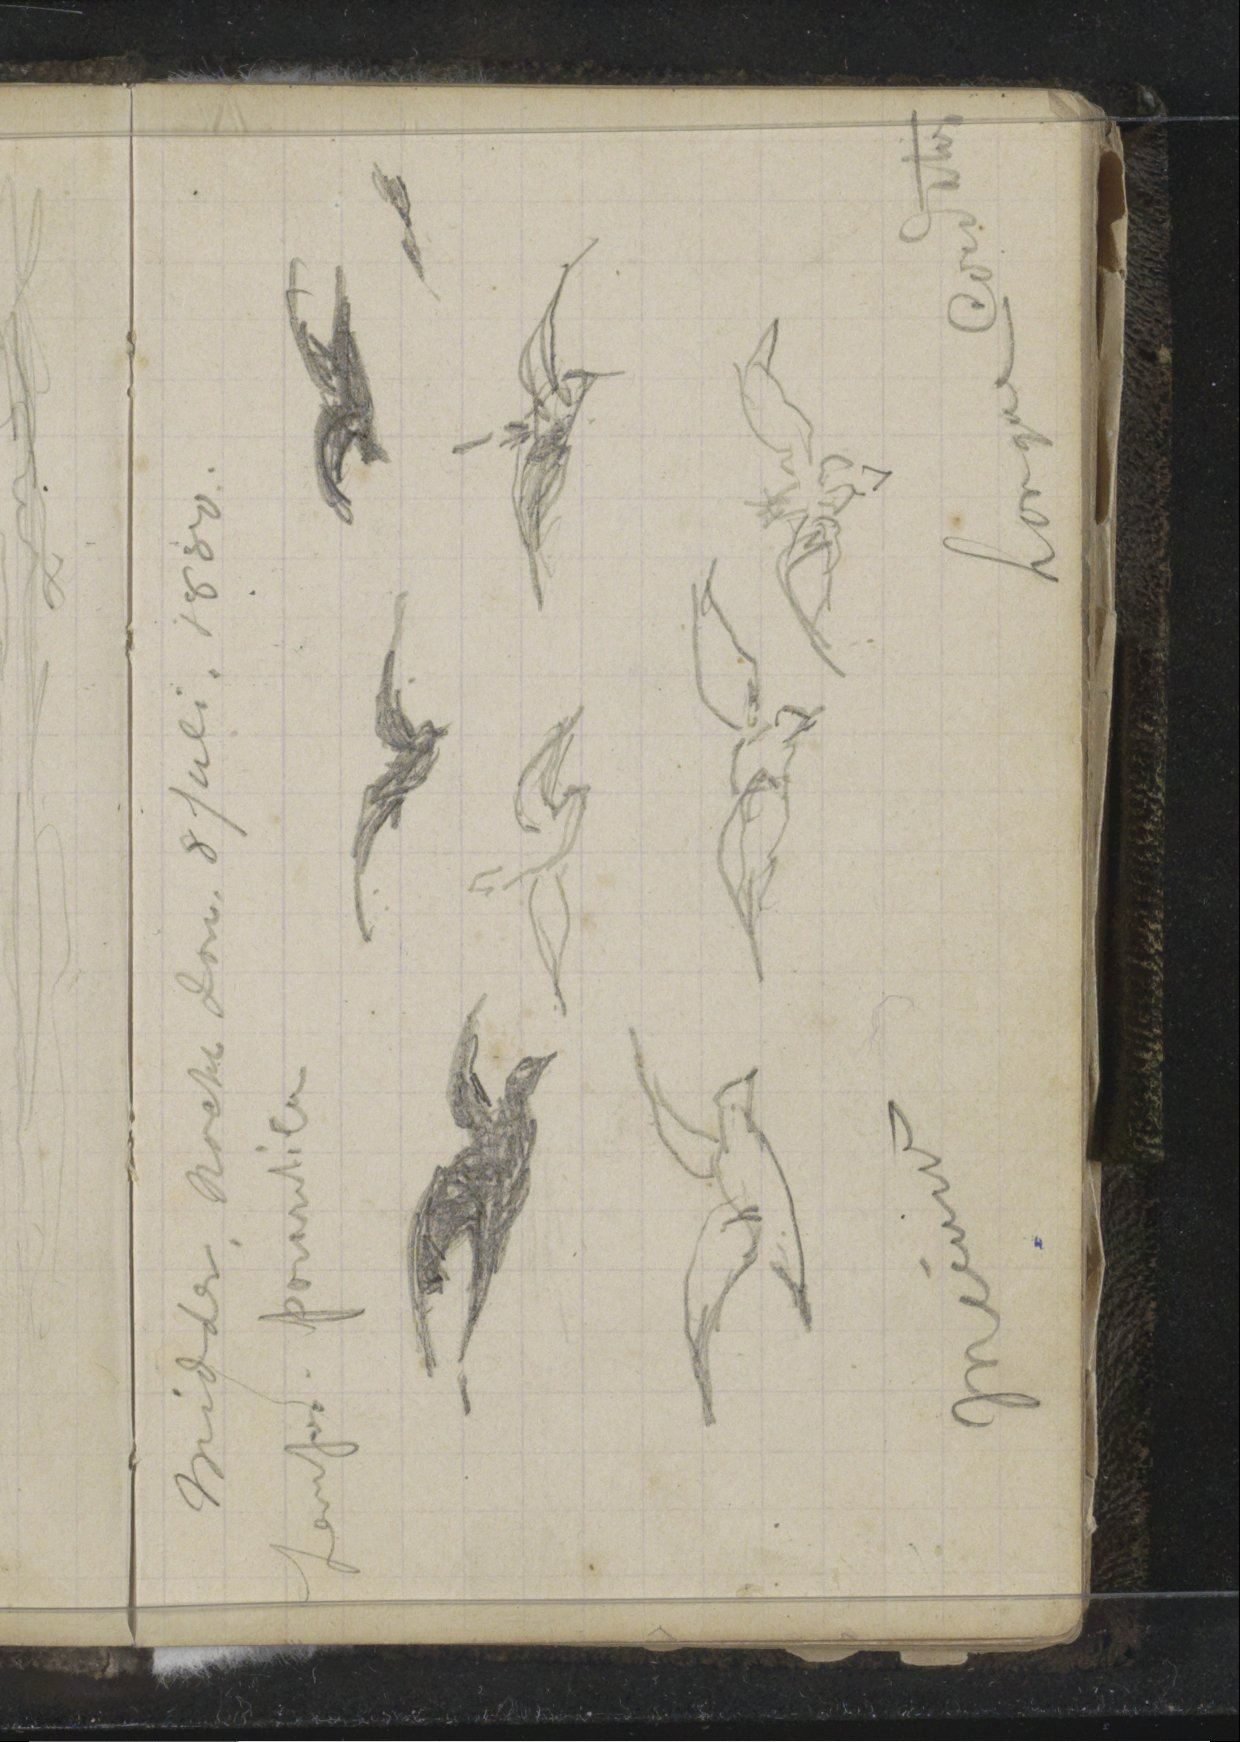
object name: sketchbook leaf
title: Verschillende vogels in vlucht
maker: louis apol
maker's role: draughtsman, painter, print maker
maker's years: 1850-1936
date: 1880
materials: pencil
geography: barentsz sea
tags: water-birds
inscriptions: annotation: ‘Midder nacht zon, 8 juli 1880 / [...] Pararctica / Meeuw / Lo[...] Cordatis’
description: Onder andere meeuwen. Mogelijk getekend gedurende de middernachtzon. Blad 11 recto uit een schetsboek met 110 bladen betekend tijdens de expeditie naar Nova Zembla in 1880.